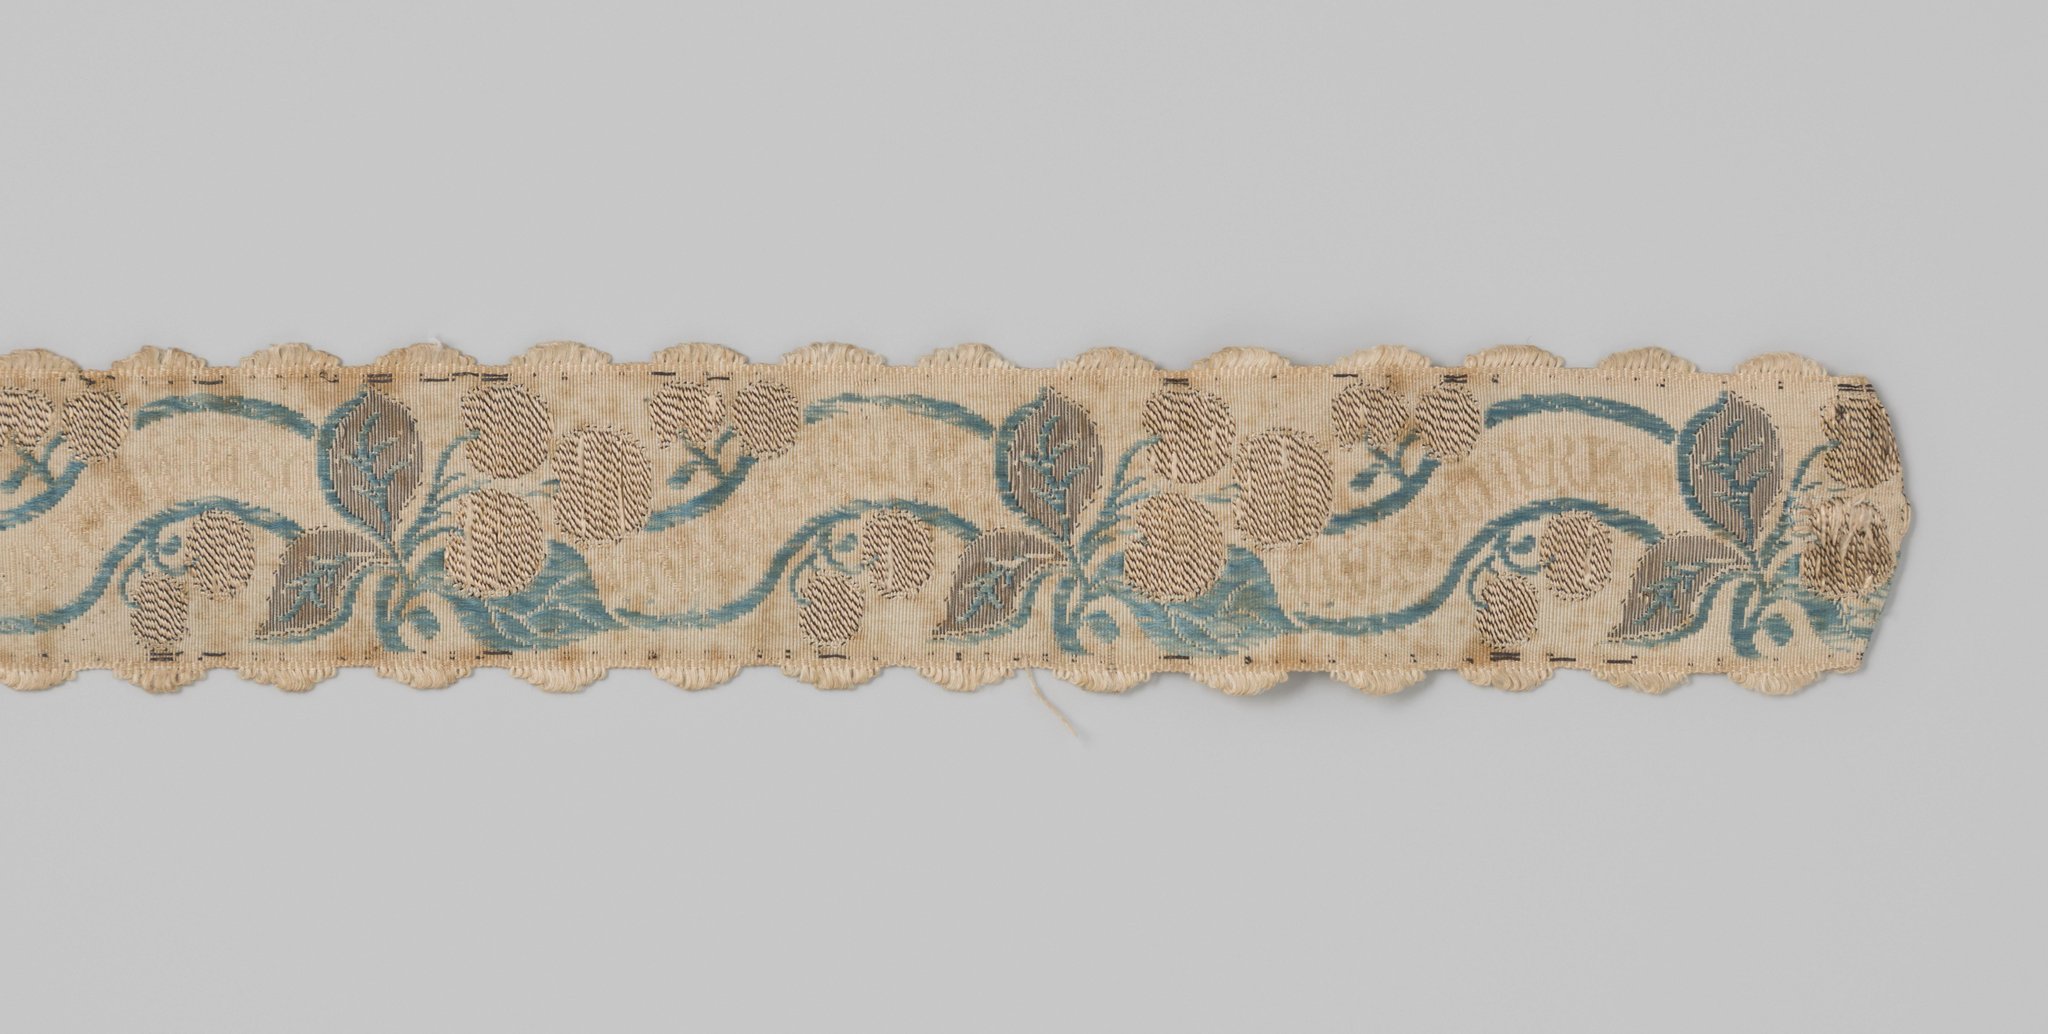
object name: ribbon material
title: Lint of kousenband van witte ripszijde, met in brocheerwerk een zich herhalend ingeweven patroon van oranjeappels met loof afgewisseld met een banderol waarop de tekst: VIVAT W.C.H. FRISO (= Willem Karel Hendrik Friso, vanaf 1747 tot aan zijn dood in 1751 de eerste erfstadhouder van de Verenigde Nederlanden)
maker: Anonymous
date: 1711-1751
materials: silk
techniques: brocade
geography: netherlands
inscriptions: inscription: ‘VIVAT W.C.H. FRISO’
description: Lint of kousenband van witte ripszijde, versierd met in brocheerwerk een zich herhalend ingeweven patroon van oranjeappels met loof afgewisseld met een banderol waarop de tekst: VIVAT W.C.H. FRISO (= Willem Karel Hendrik Friso, vanaf 1747 tot aan zijn dood in 1751 de eerste erfstadhouder van de Verenigde Nederlanden). Het lint heeft een geschulpte rand.